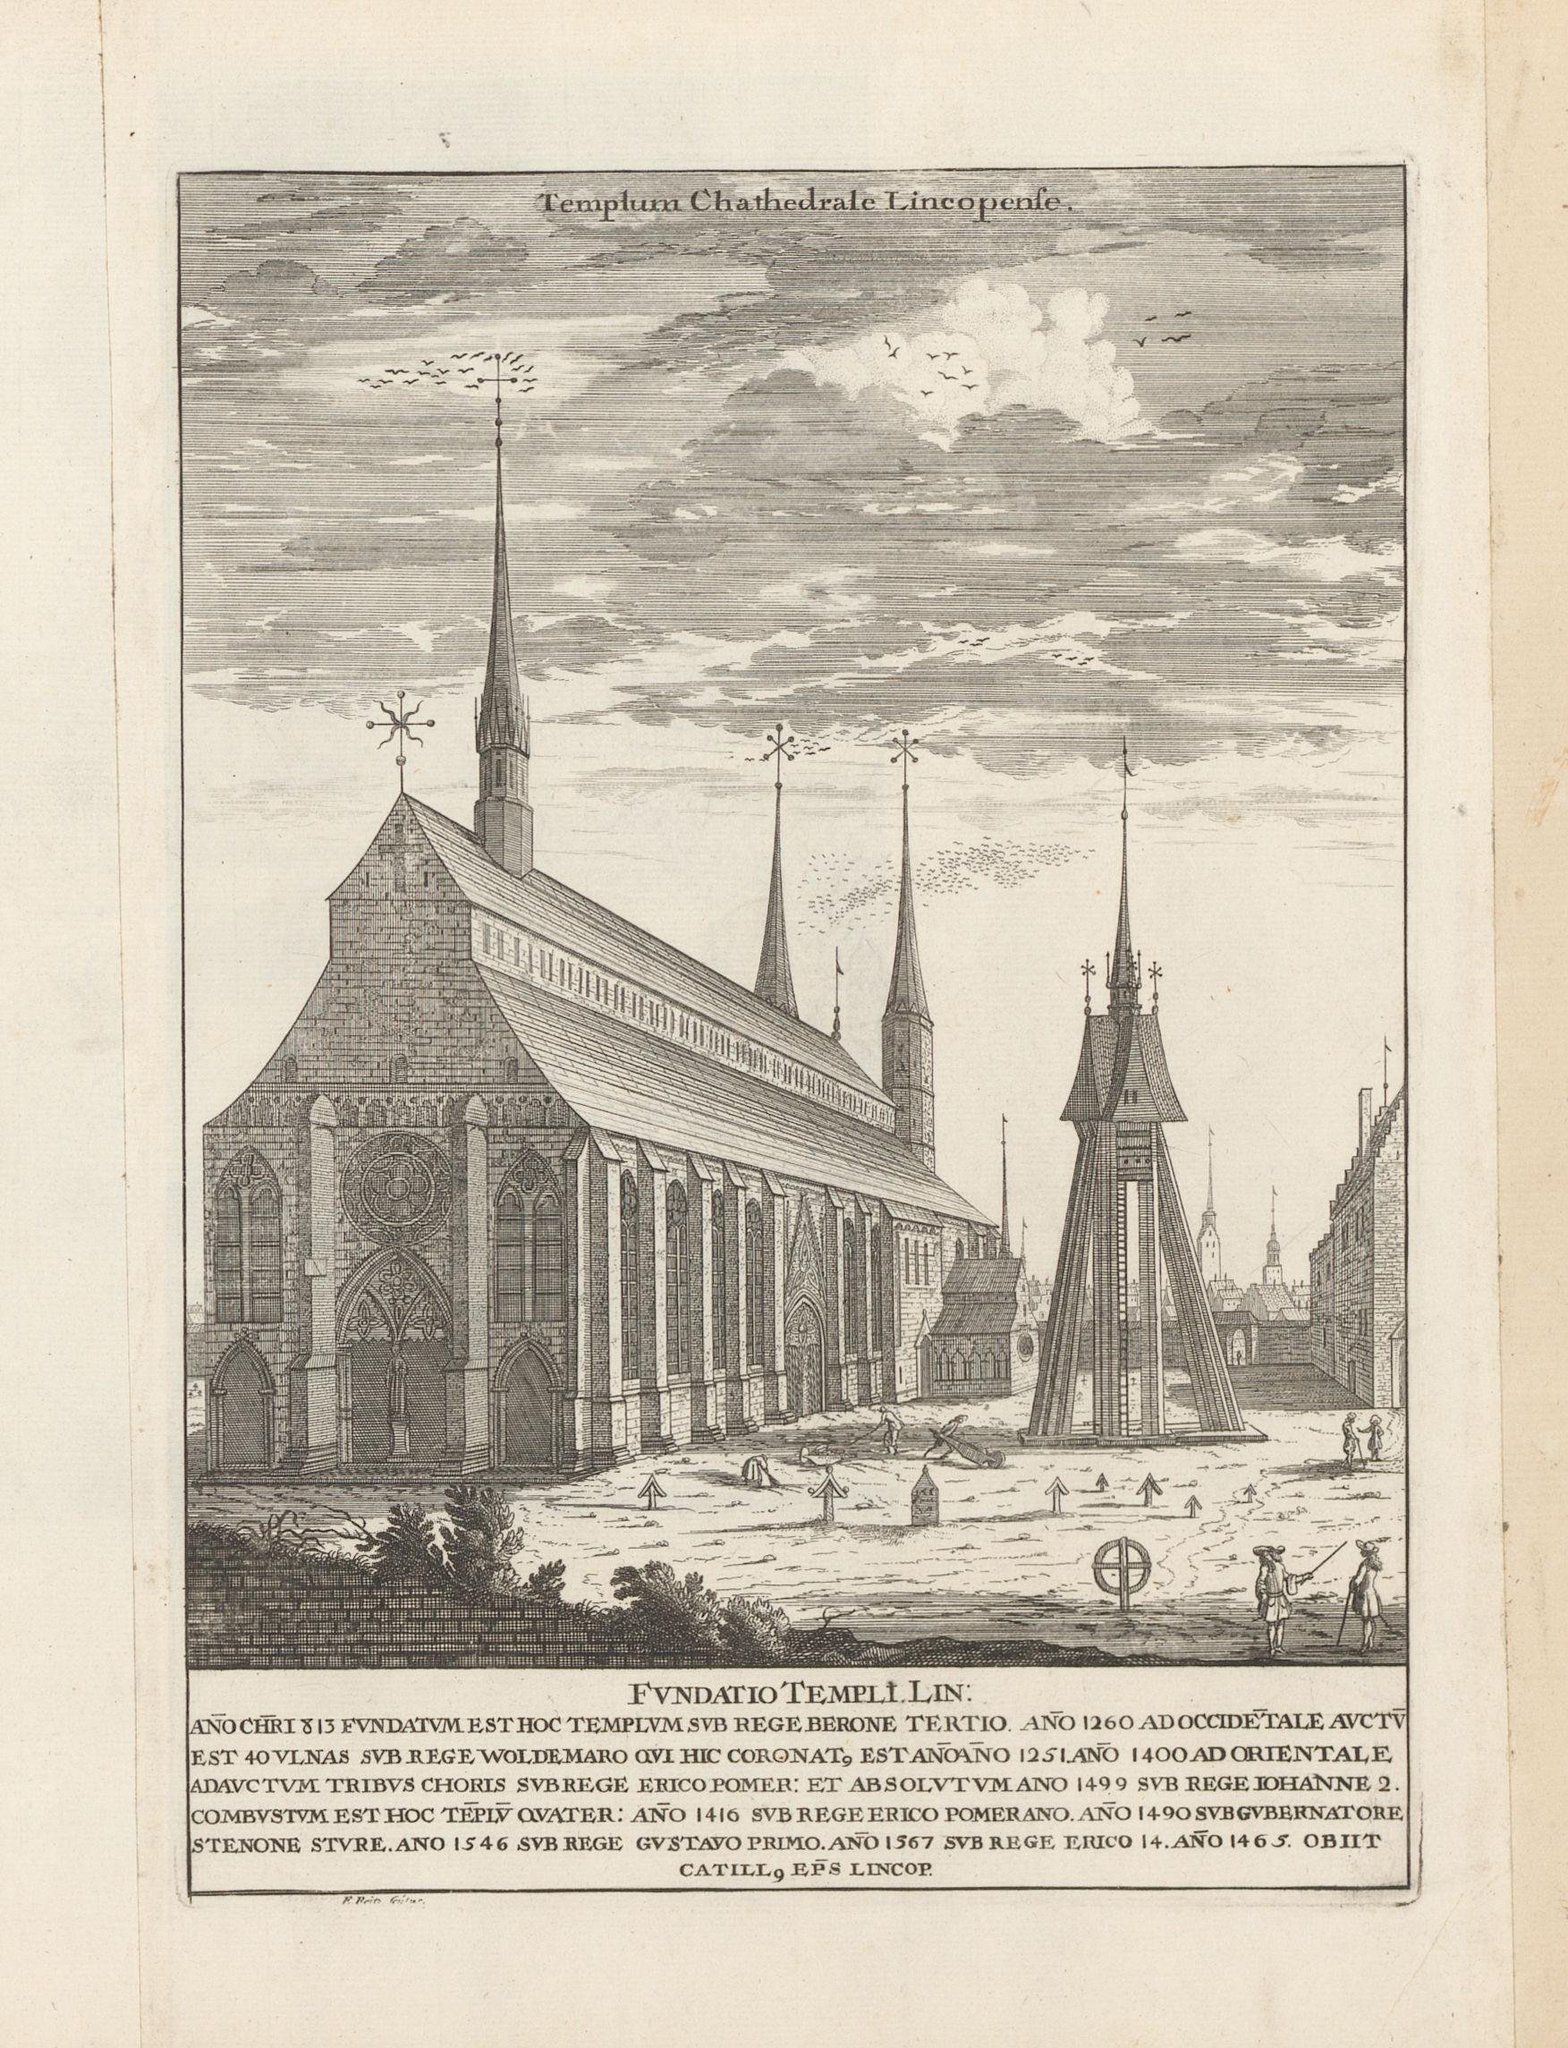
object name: album leaf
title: Suecia Antiqua et Hodierna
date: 1694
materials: paper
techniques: etching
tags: church (exterior)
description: Kungliga Biblioteket, 'Suecia': http://www.kb.se/samlingarna/Kartor-bilder/Suecia-antiqua/ (geraadpleegd november 2016).